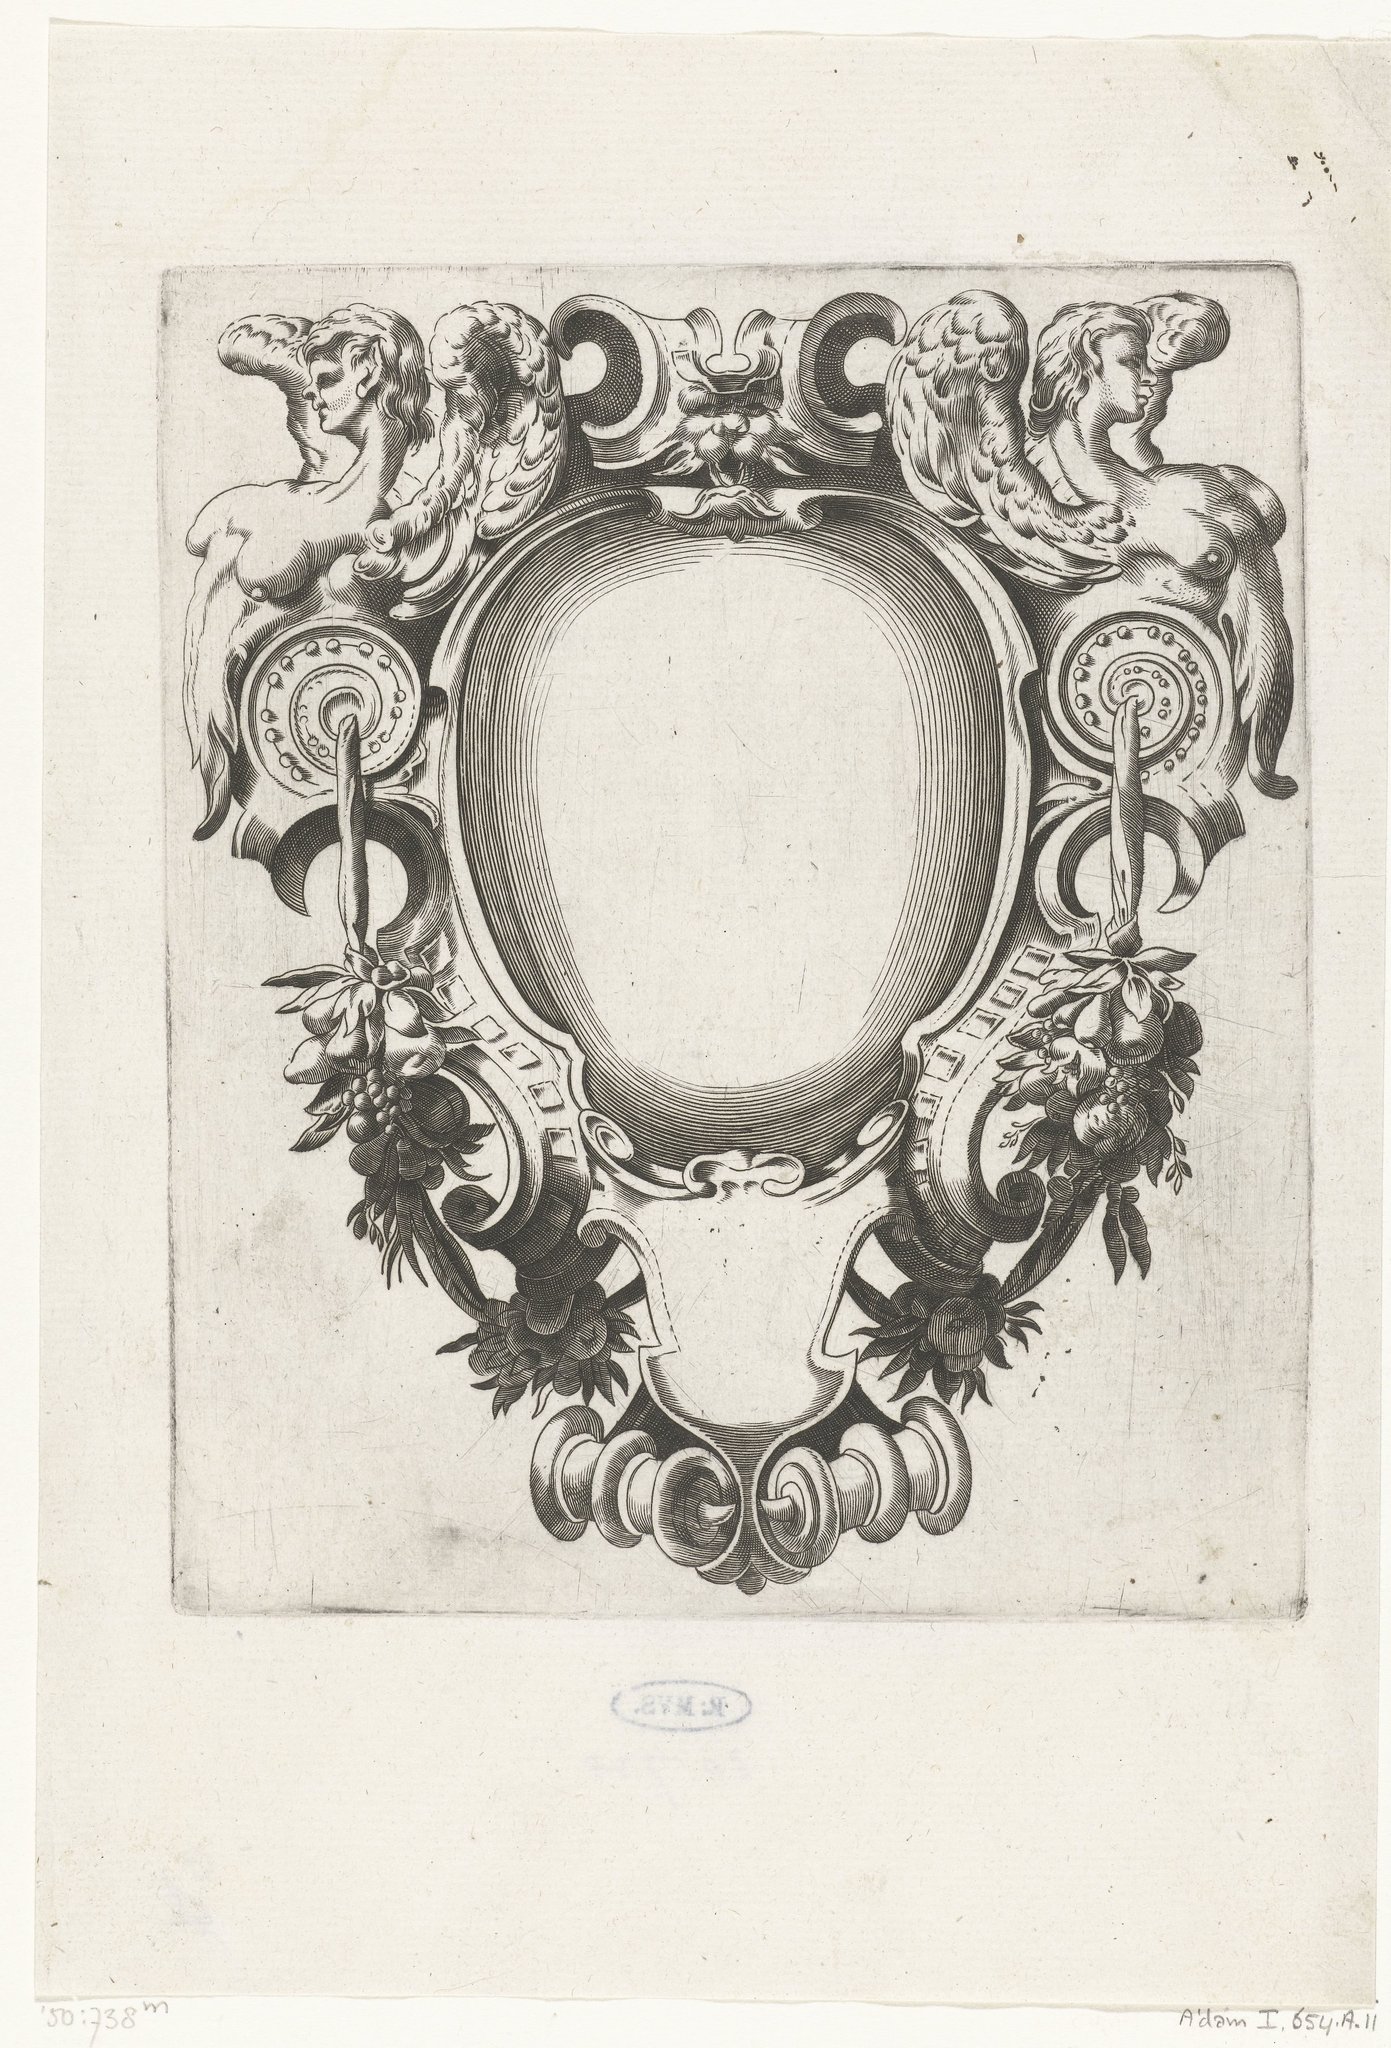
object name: print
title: Cartouches in omlijstingen van rolwerk met grotesken, guirlandes en mascarons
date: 1628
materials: paper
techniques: engraving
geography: france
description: Tegenzijdige kopie naar blad 12 uit serie met cartouches in omlijstingen van rolwerk met grotesken, guirlandes en mascarons uitgegeven door Pierre Mariette.